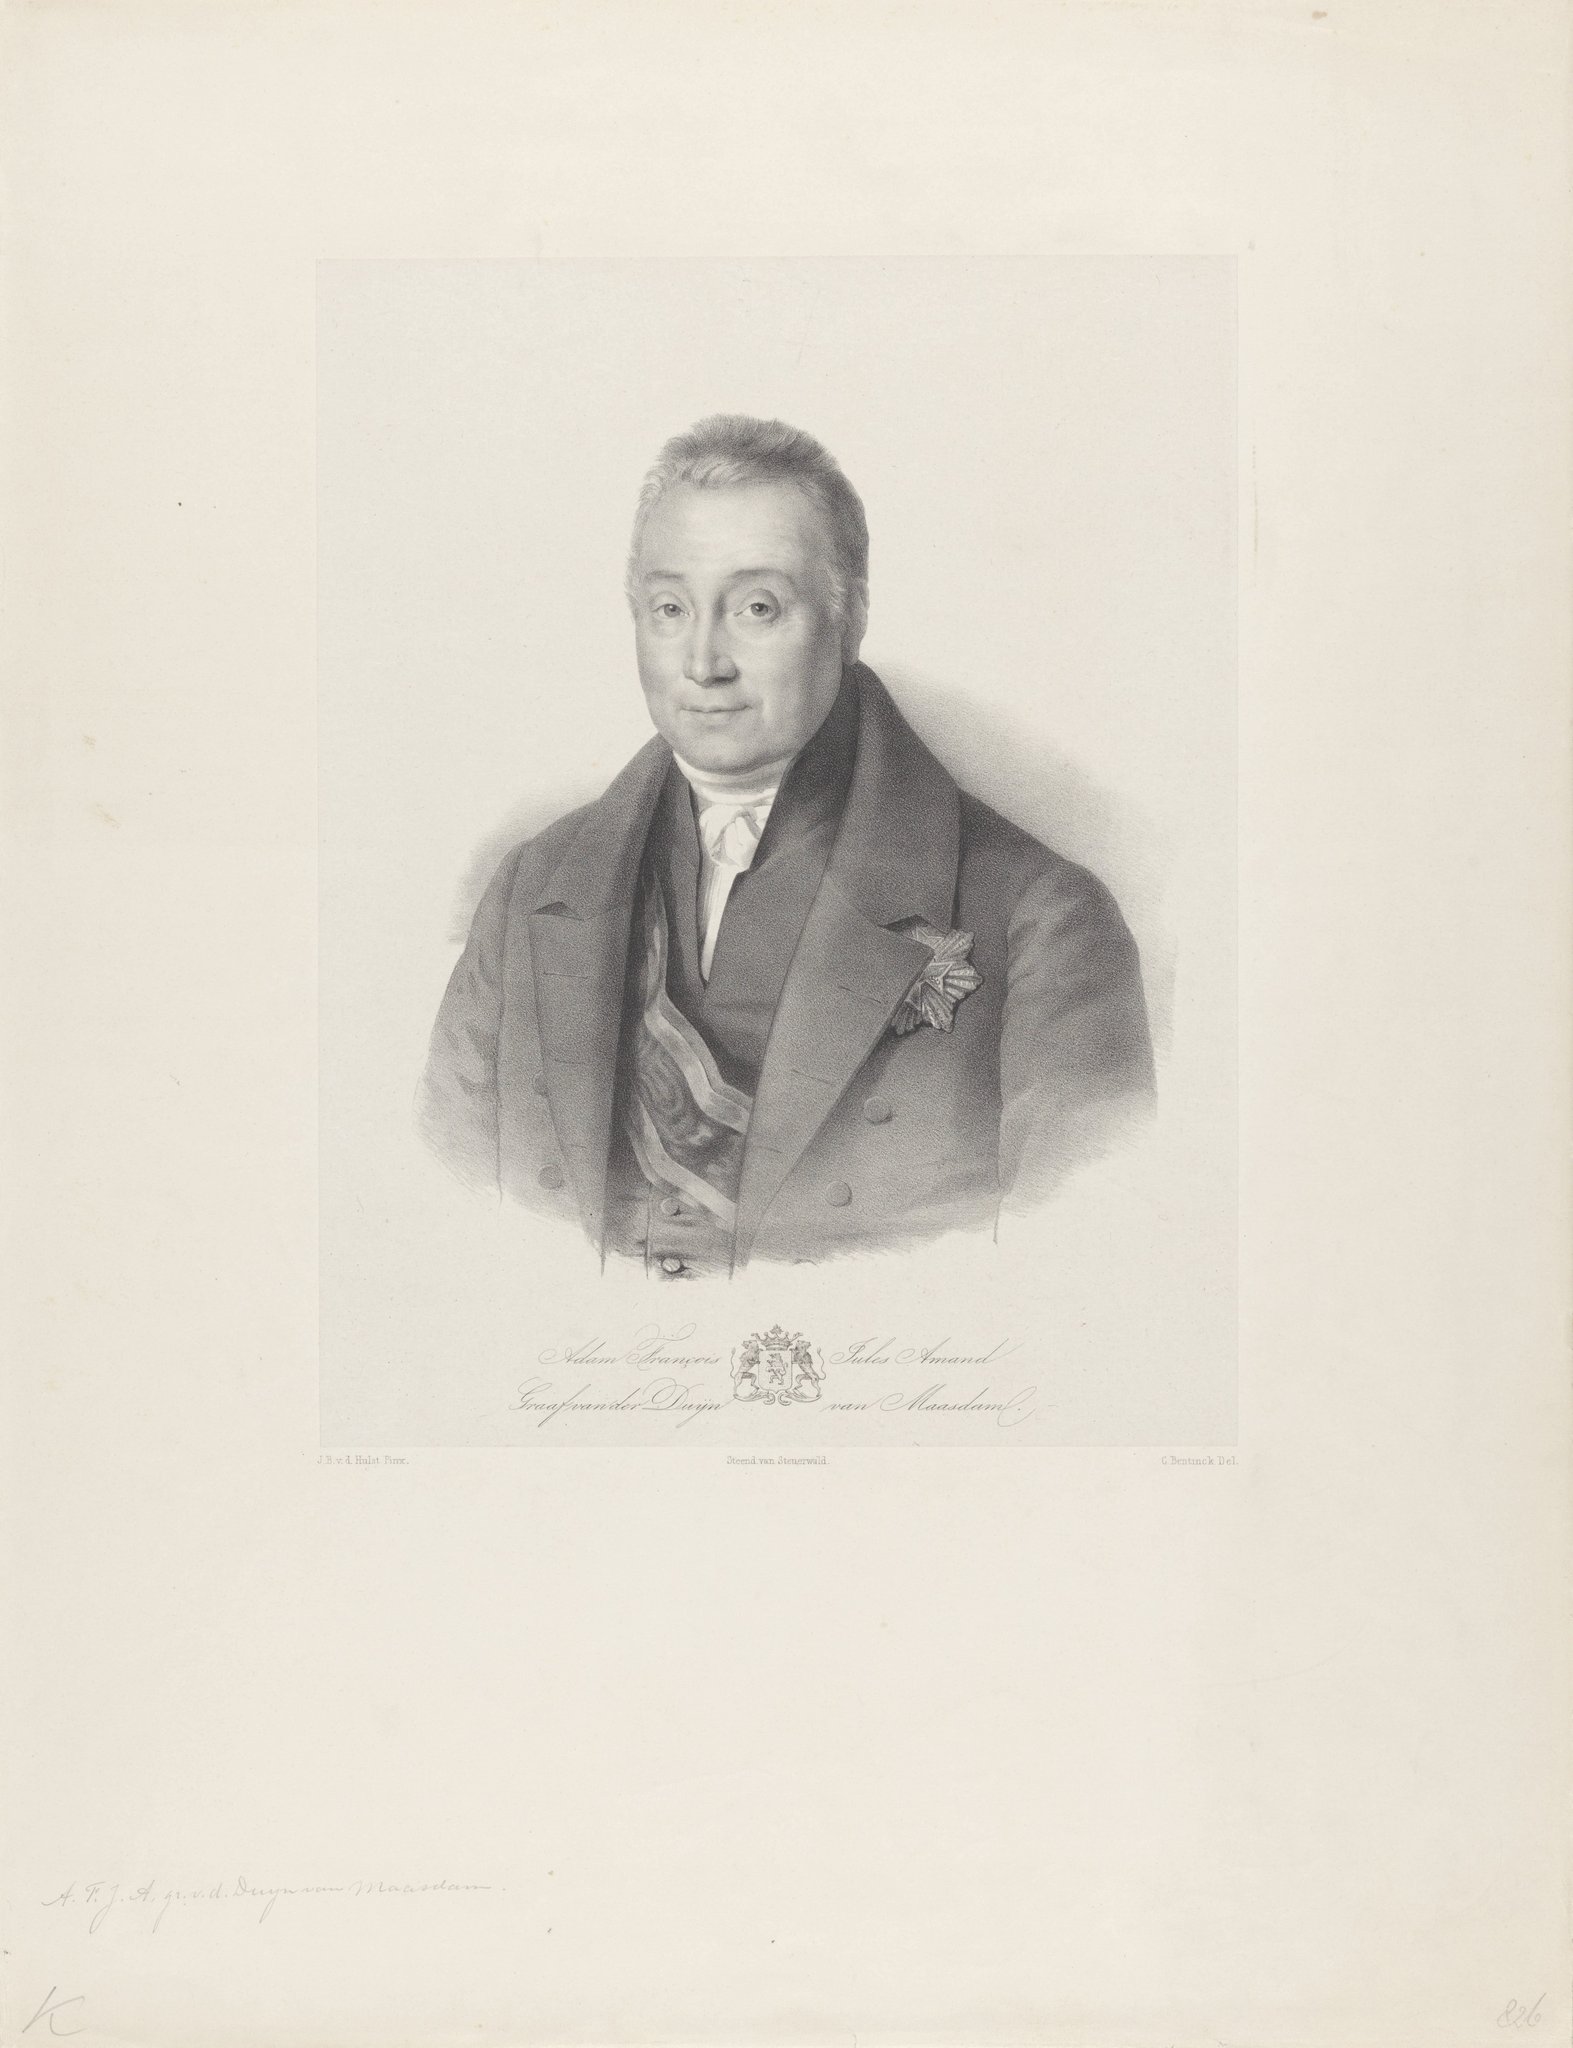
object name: print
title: Portret van Frans Adam van der Duyn van Maasdam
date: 1839-1849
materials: paper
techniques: lithograph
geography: netherlands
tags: the hague, adam françois jules armand van der duyn, knighthood order, historical persons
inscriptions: collector's mark: Lugt 2228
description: De geportretteerde draagt een sjerp en een decoratie op zijn borst. Onder het portret zijn naam, familiewapen en titels.